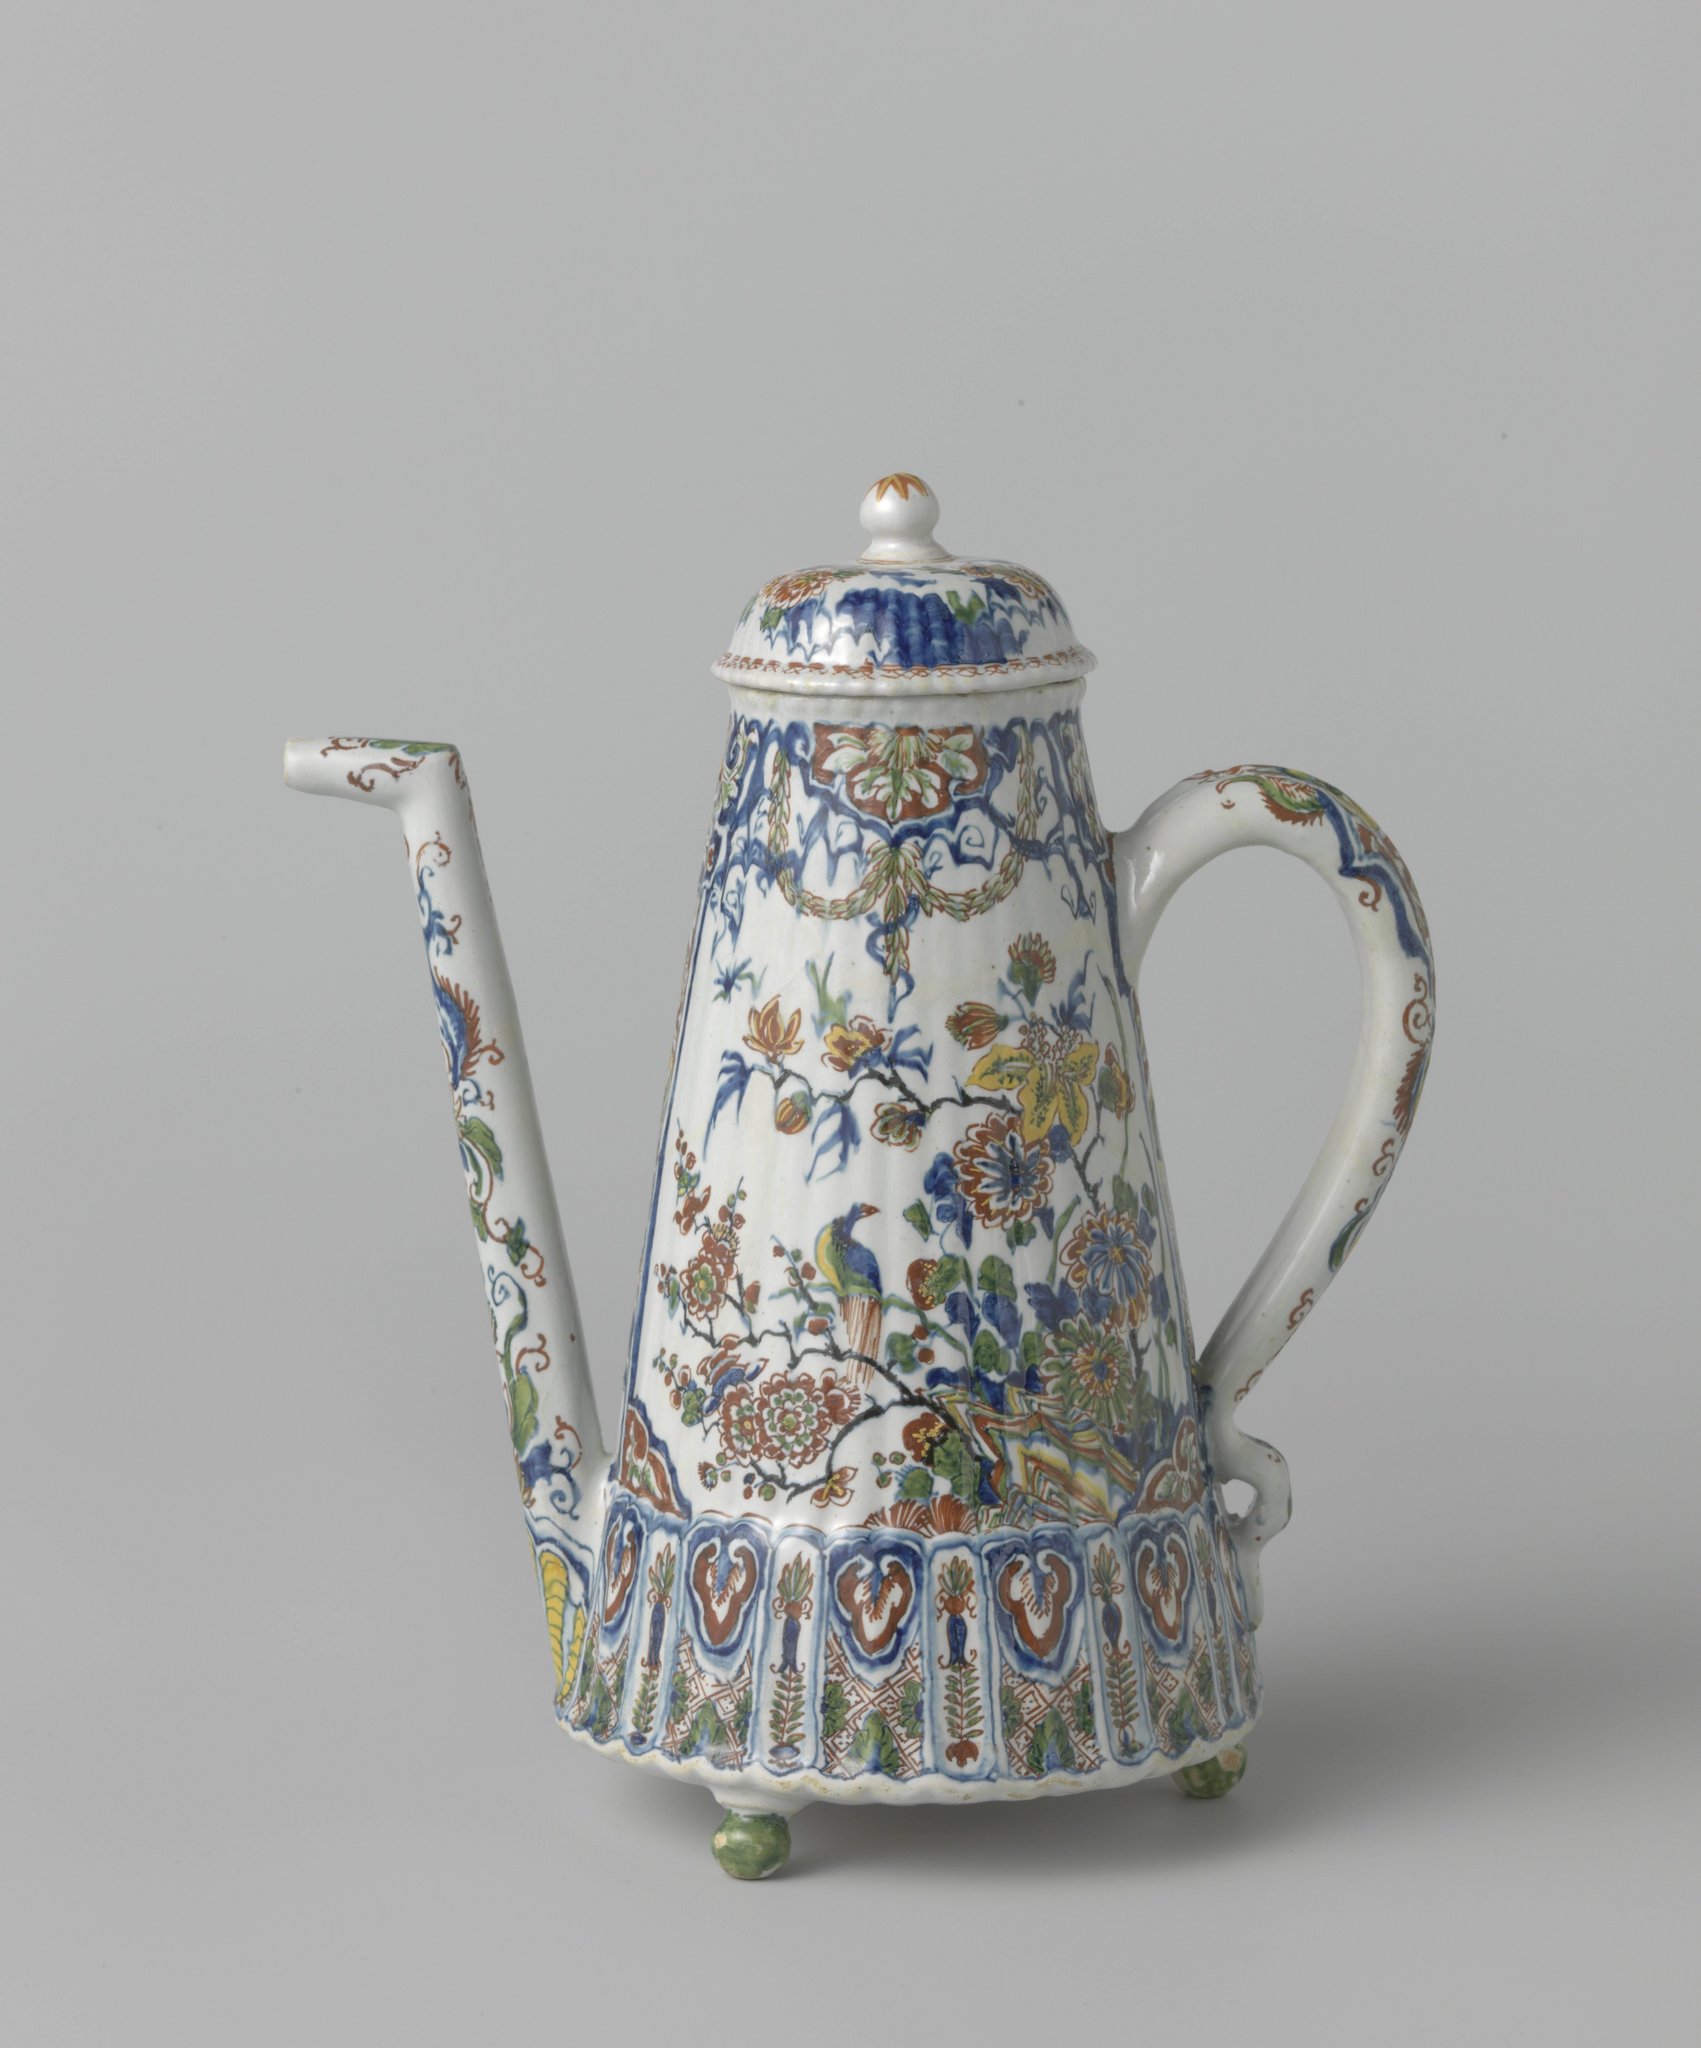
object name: vessel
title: Deksel behorend bij conisch geribde en veelkleurig beschilderde koffiekan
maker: lambertus van eenhoorn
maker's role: plateelbakker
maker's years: 1651-1721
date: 1695-1715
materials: earthenware, glaze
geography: delft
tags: flowers ~ ornament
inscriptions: mark: ‘LVE/ 3/ E (?)’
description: Deksel behorend bij conisch geribde en veelkleurig beschilderde koffiekan.